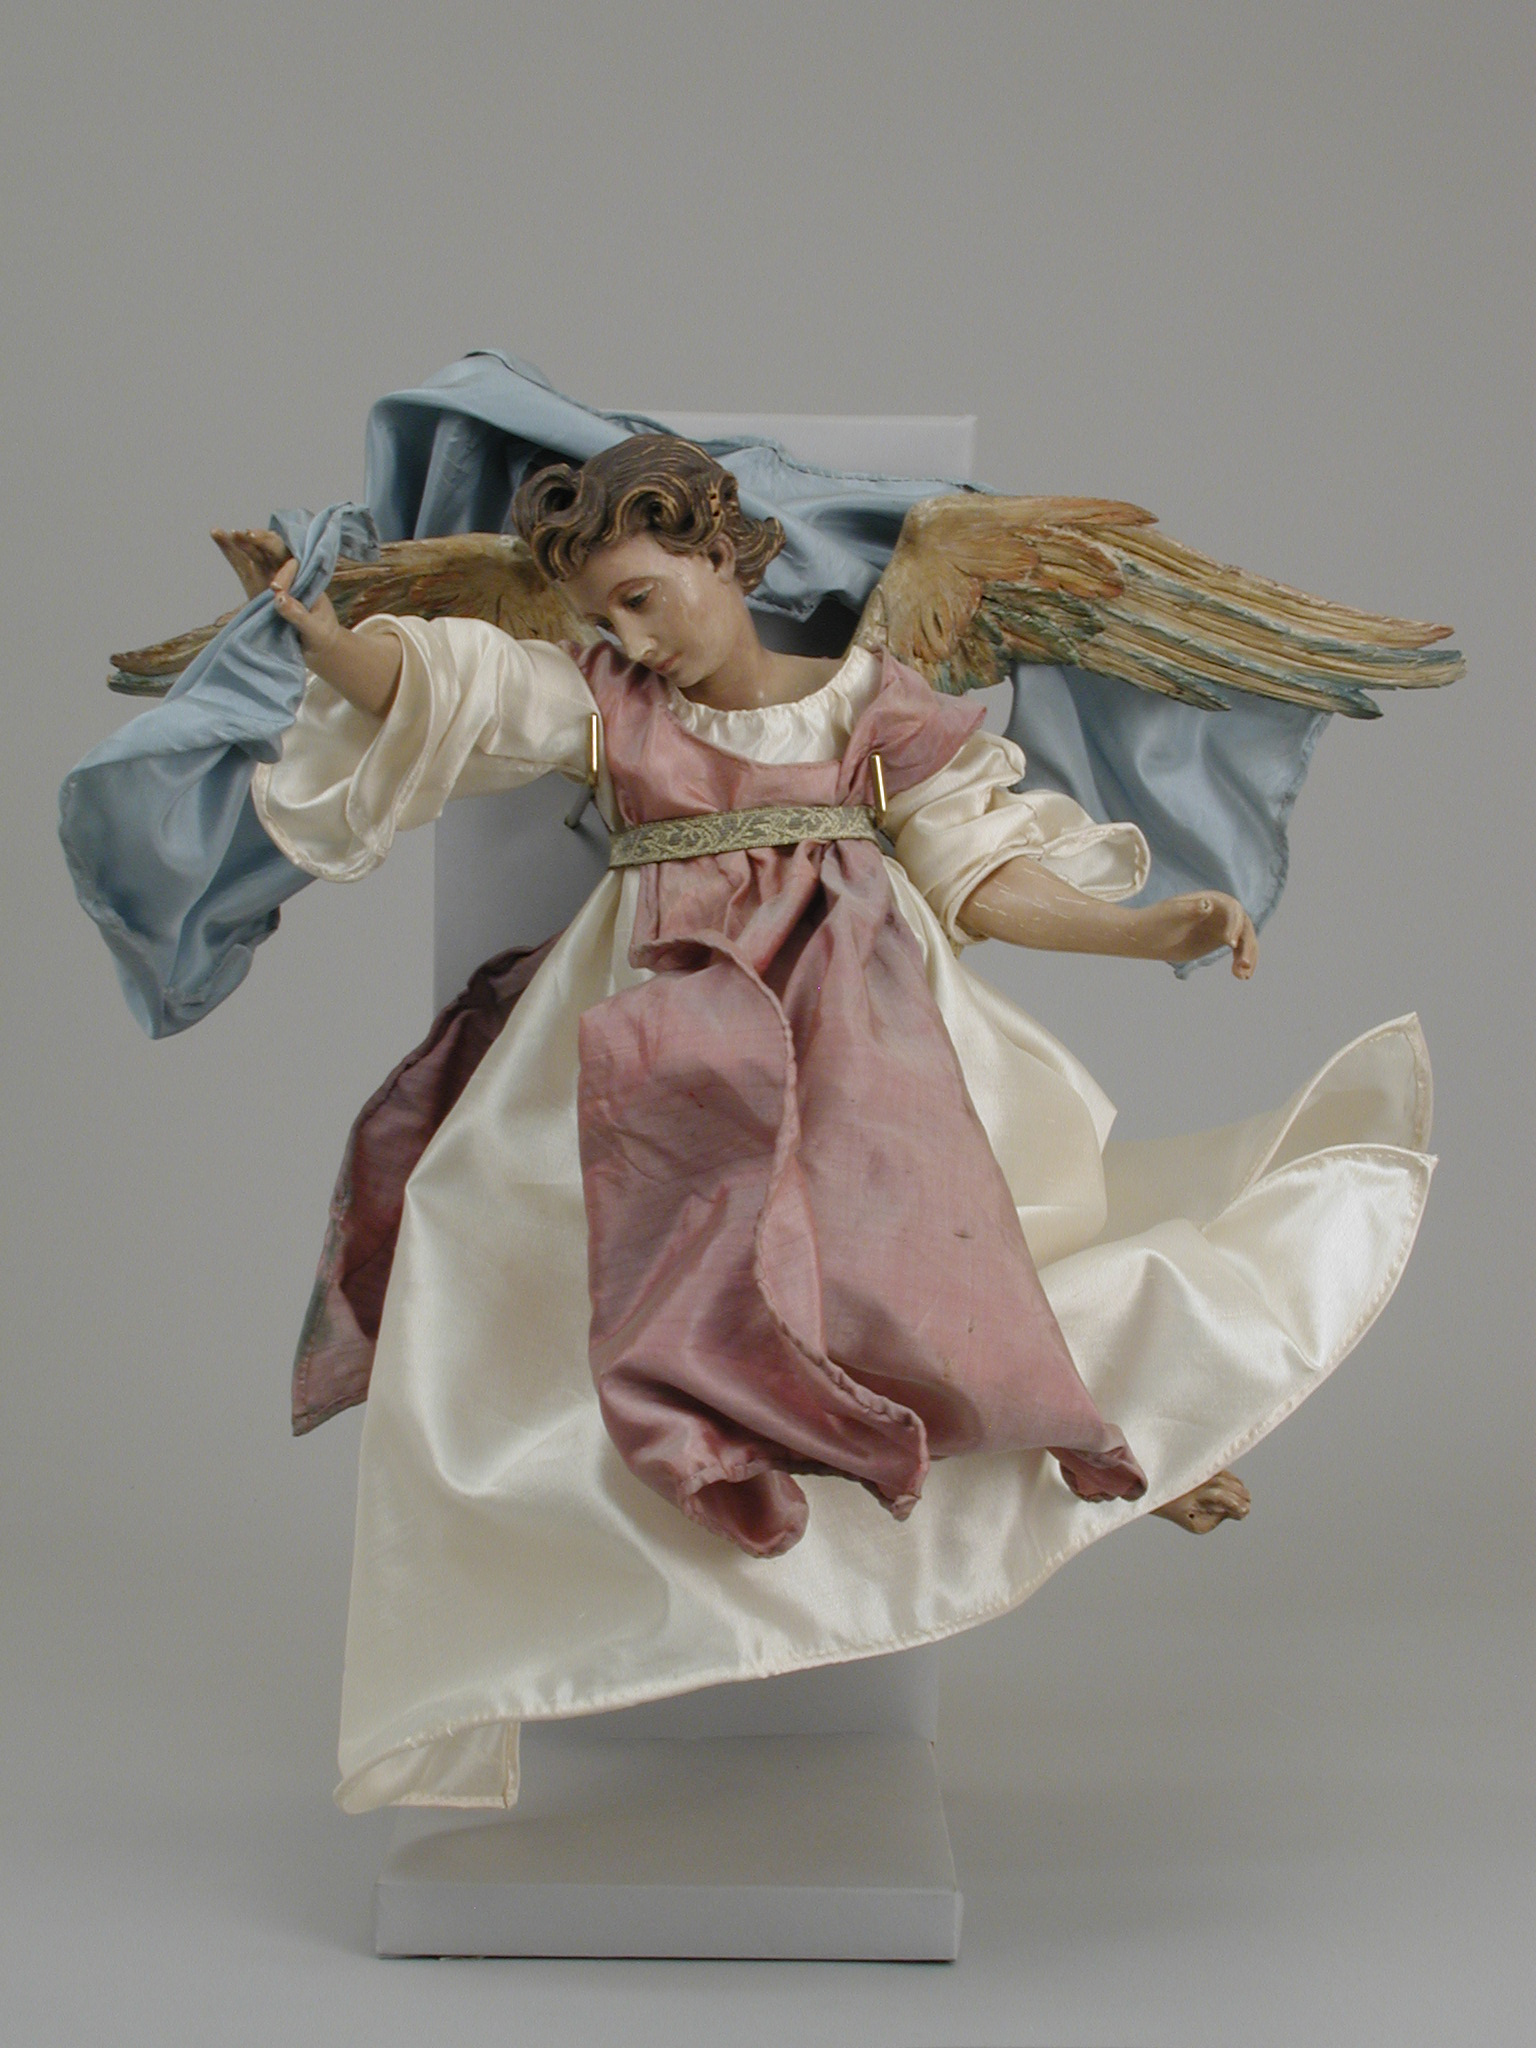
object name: crèche figure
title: Angel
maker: angelo viva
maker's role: maker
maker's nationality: italian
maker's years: 1748-1837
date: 1701-1900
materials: plaster, wood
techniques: polychrome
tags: angels